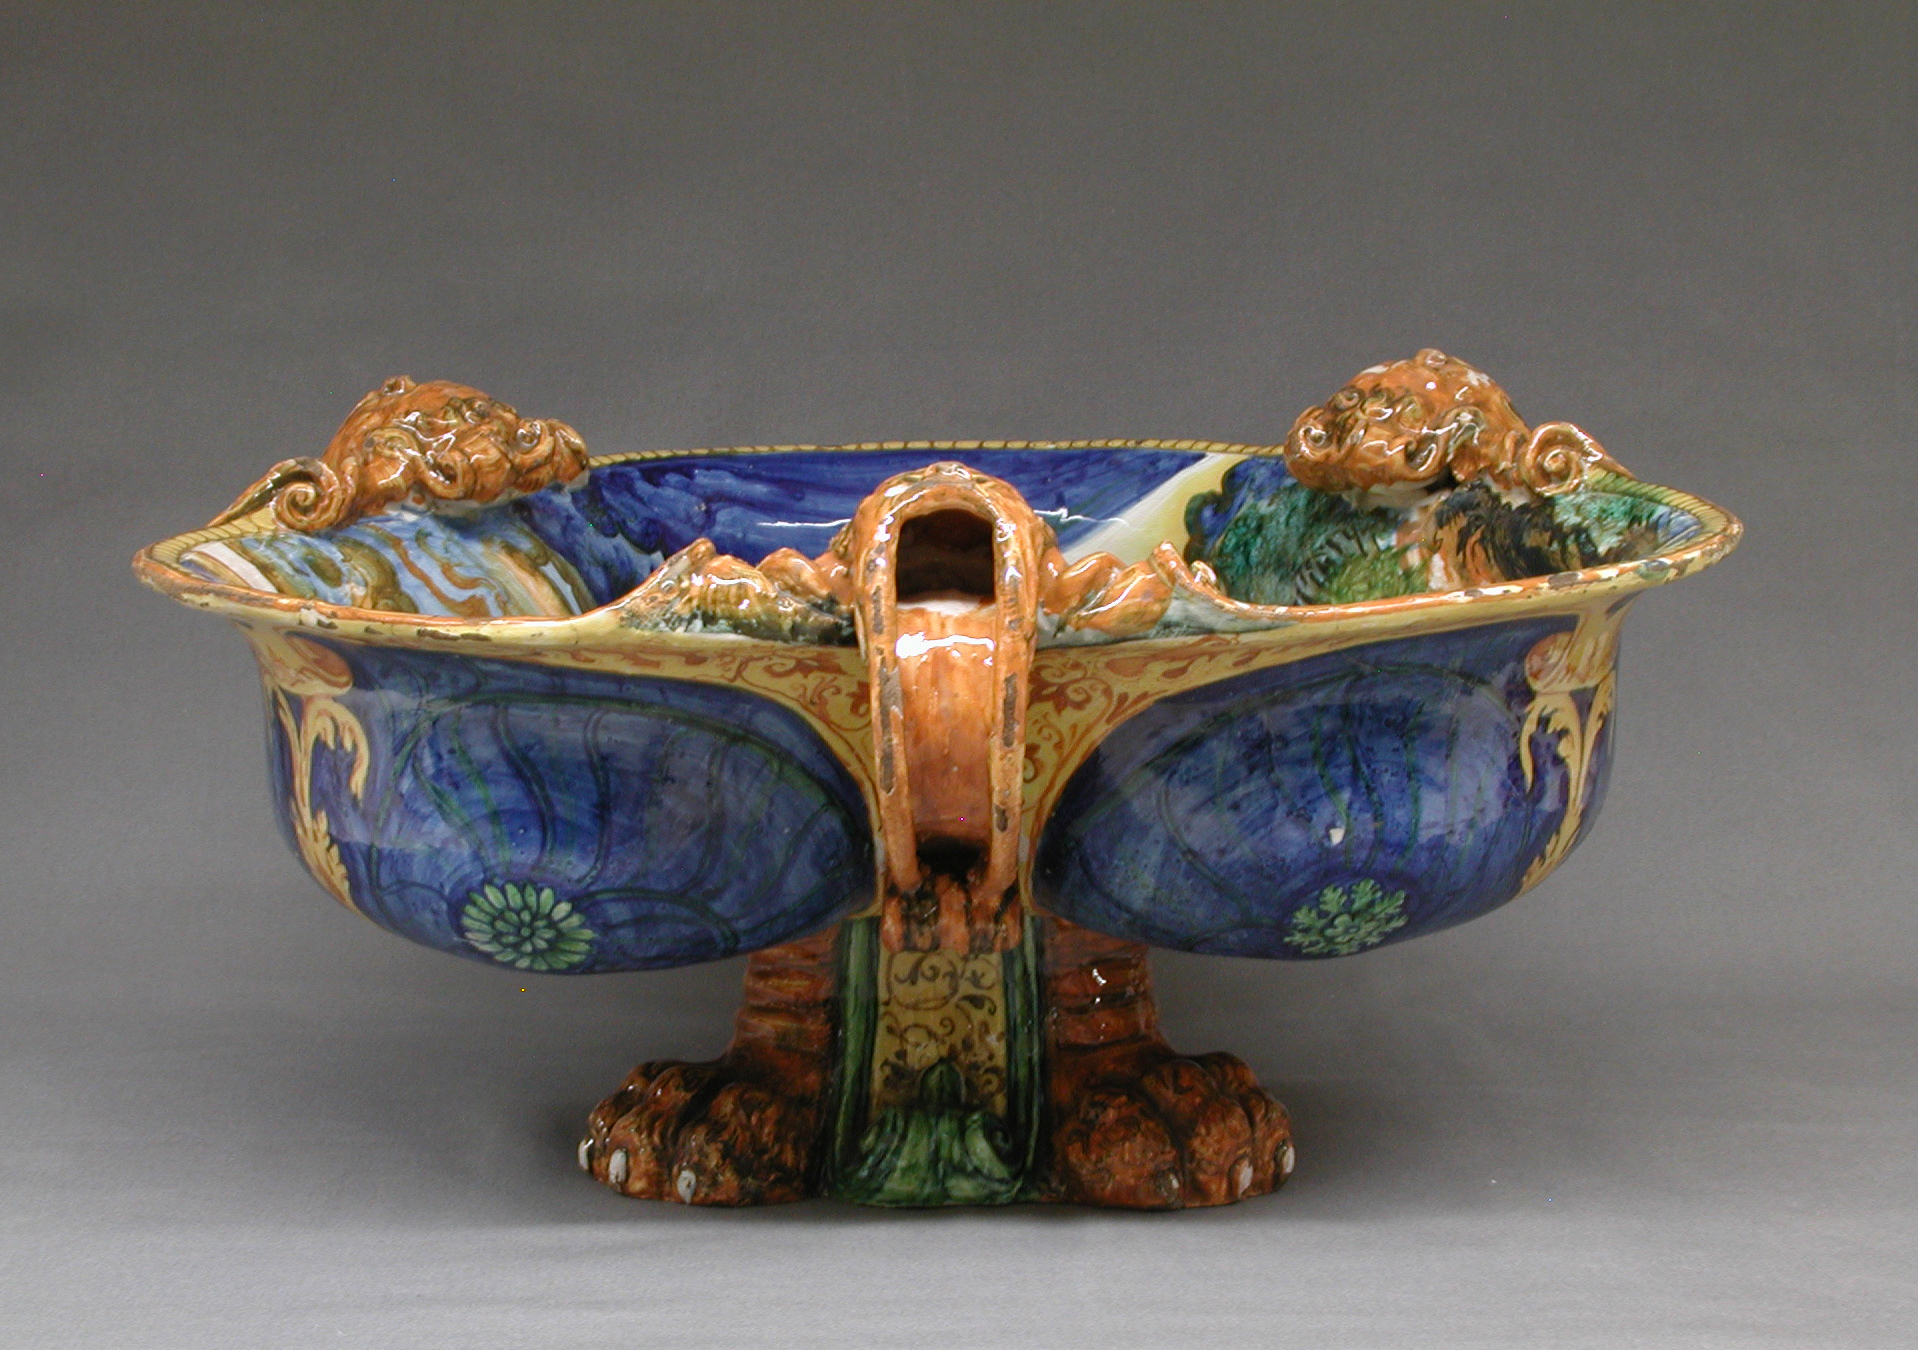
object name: cistern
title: Cistern (one of a pair)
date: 1550-1570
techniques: maiolica, glazing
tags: male nudes,female nudes